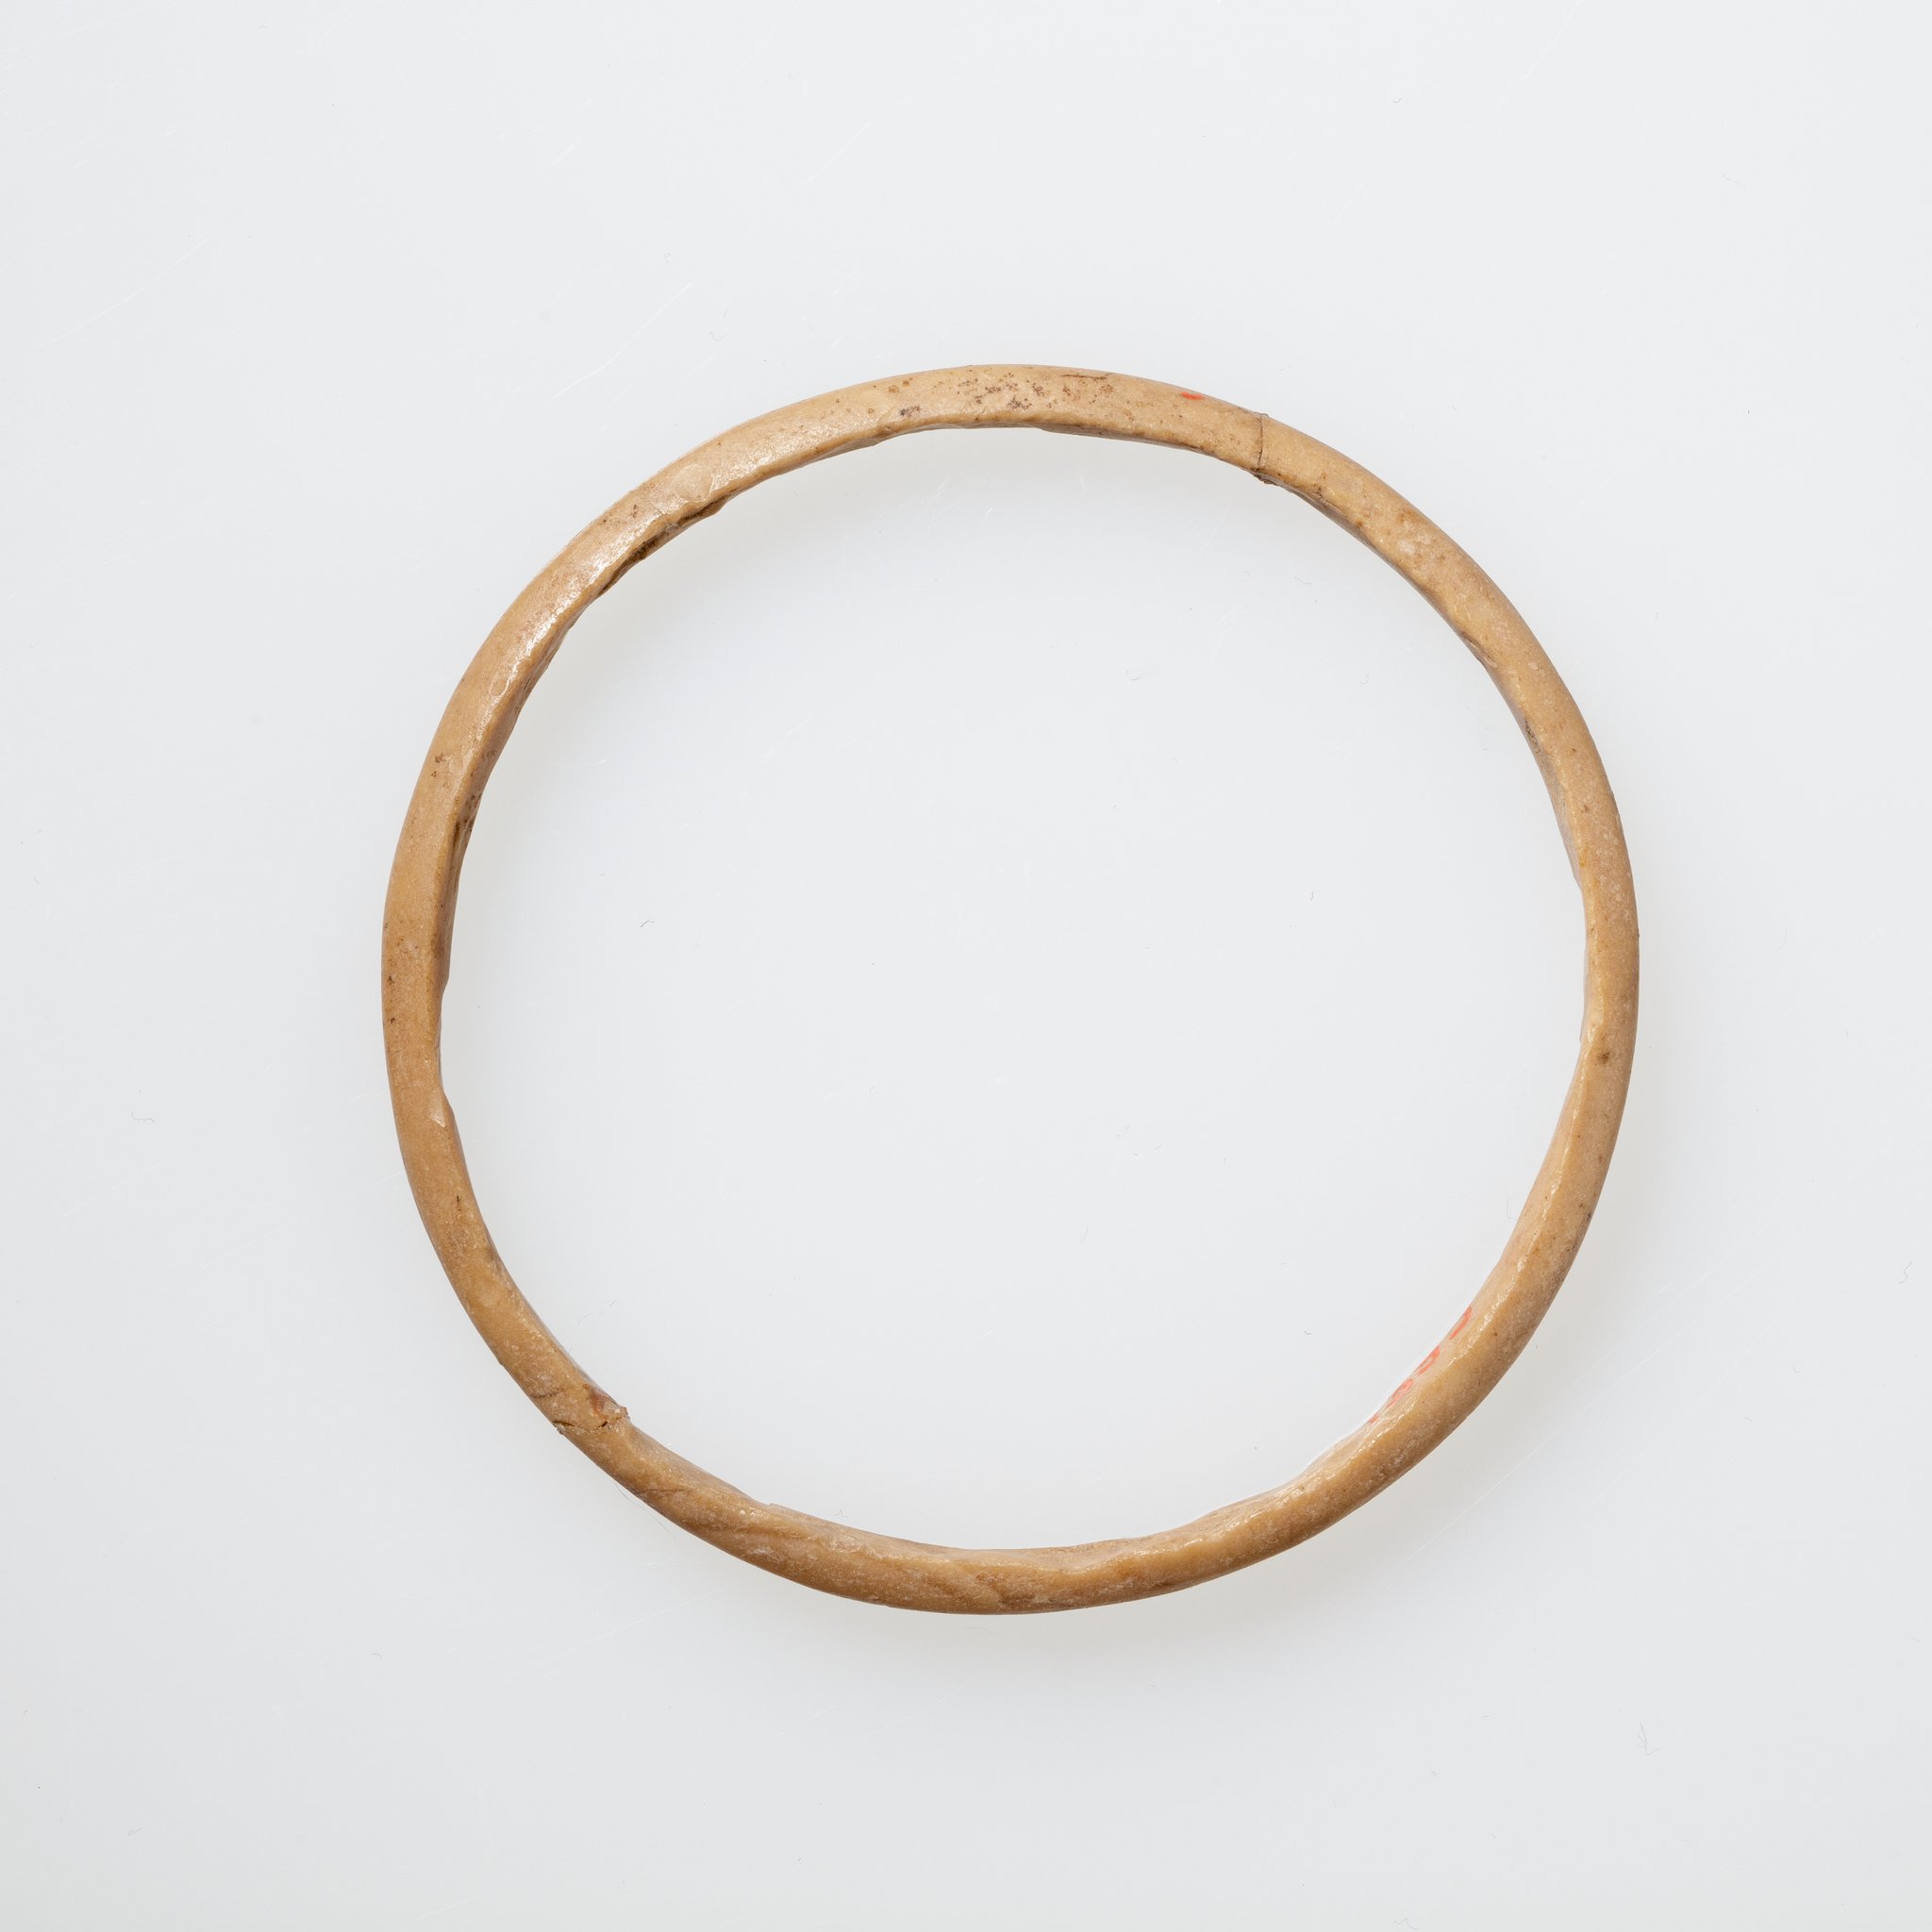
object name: bracelet bangle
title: Bracelet (Bangle)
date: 3100-2649 BCE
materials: stone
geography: egypt